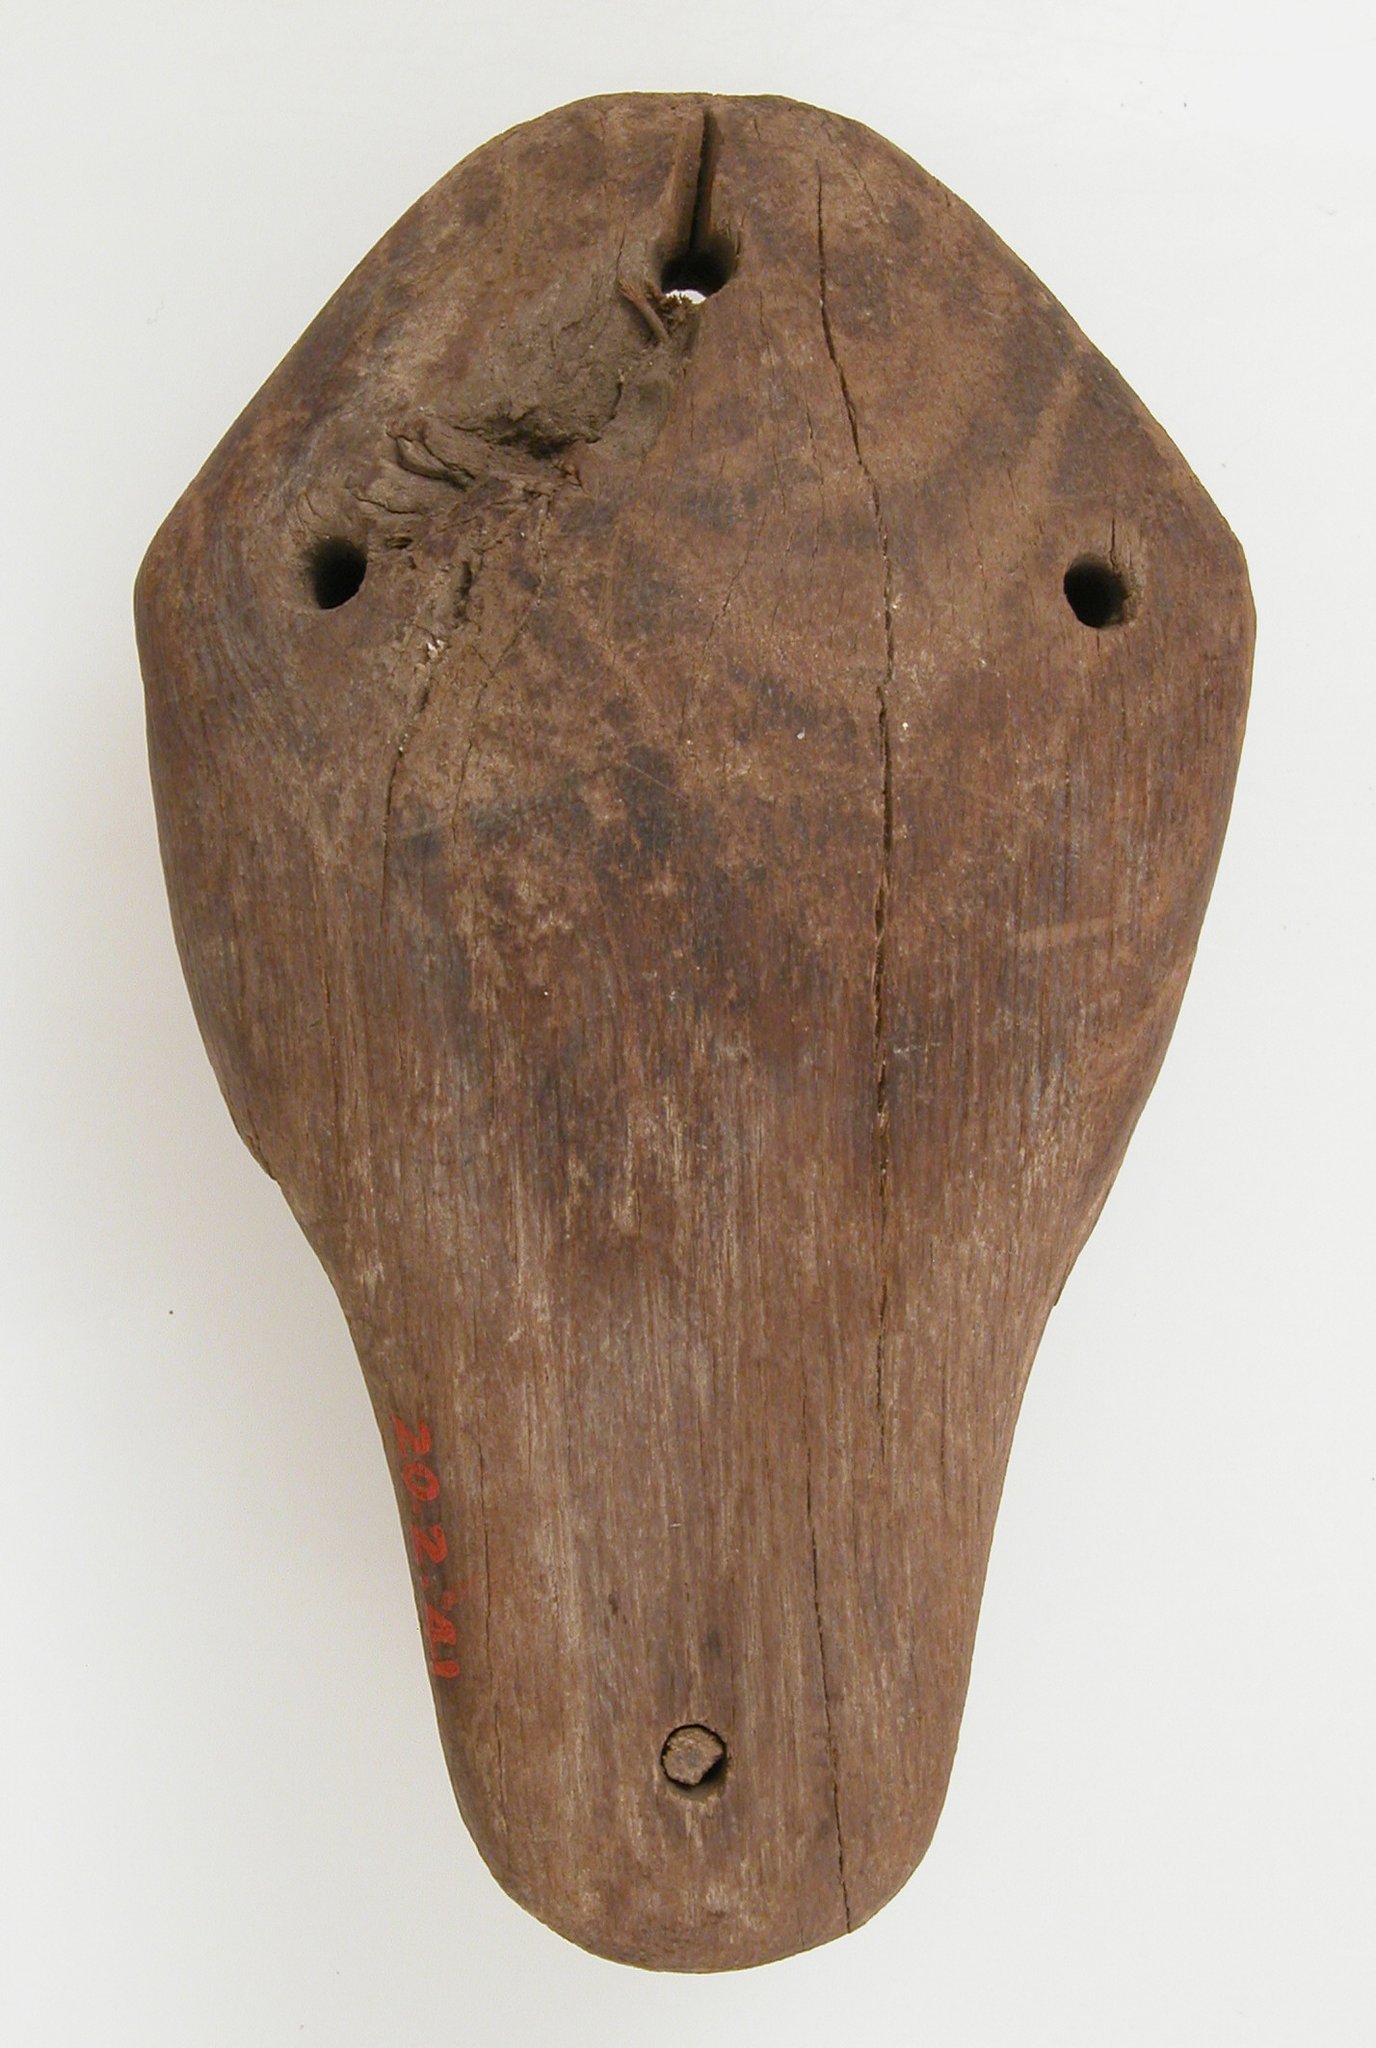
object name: pulley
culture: coptic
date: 201-500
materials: wood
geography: egypt